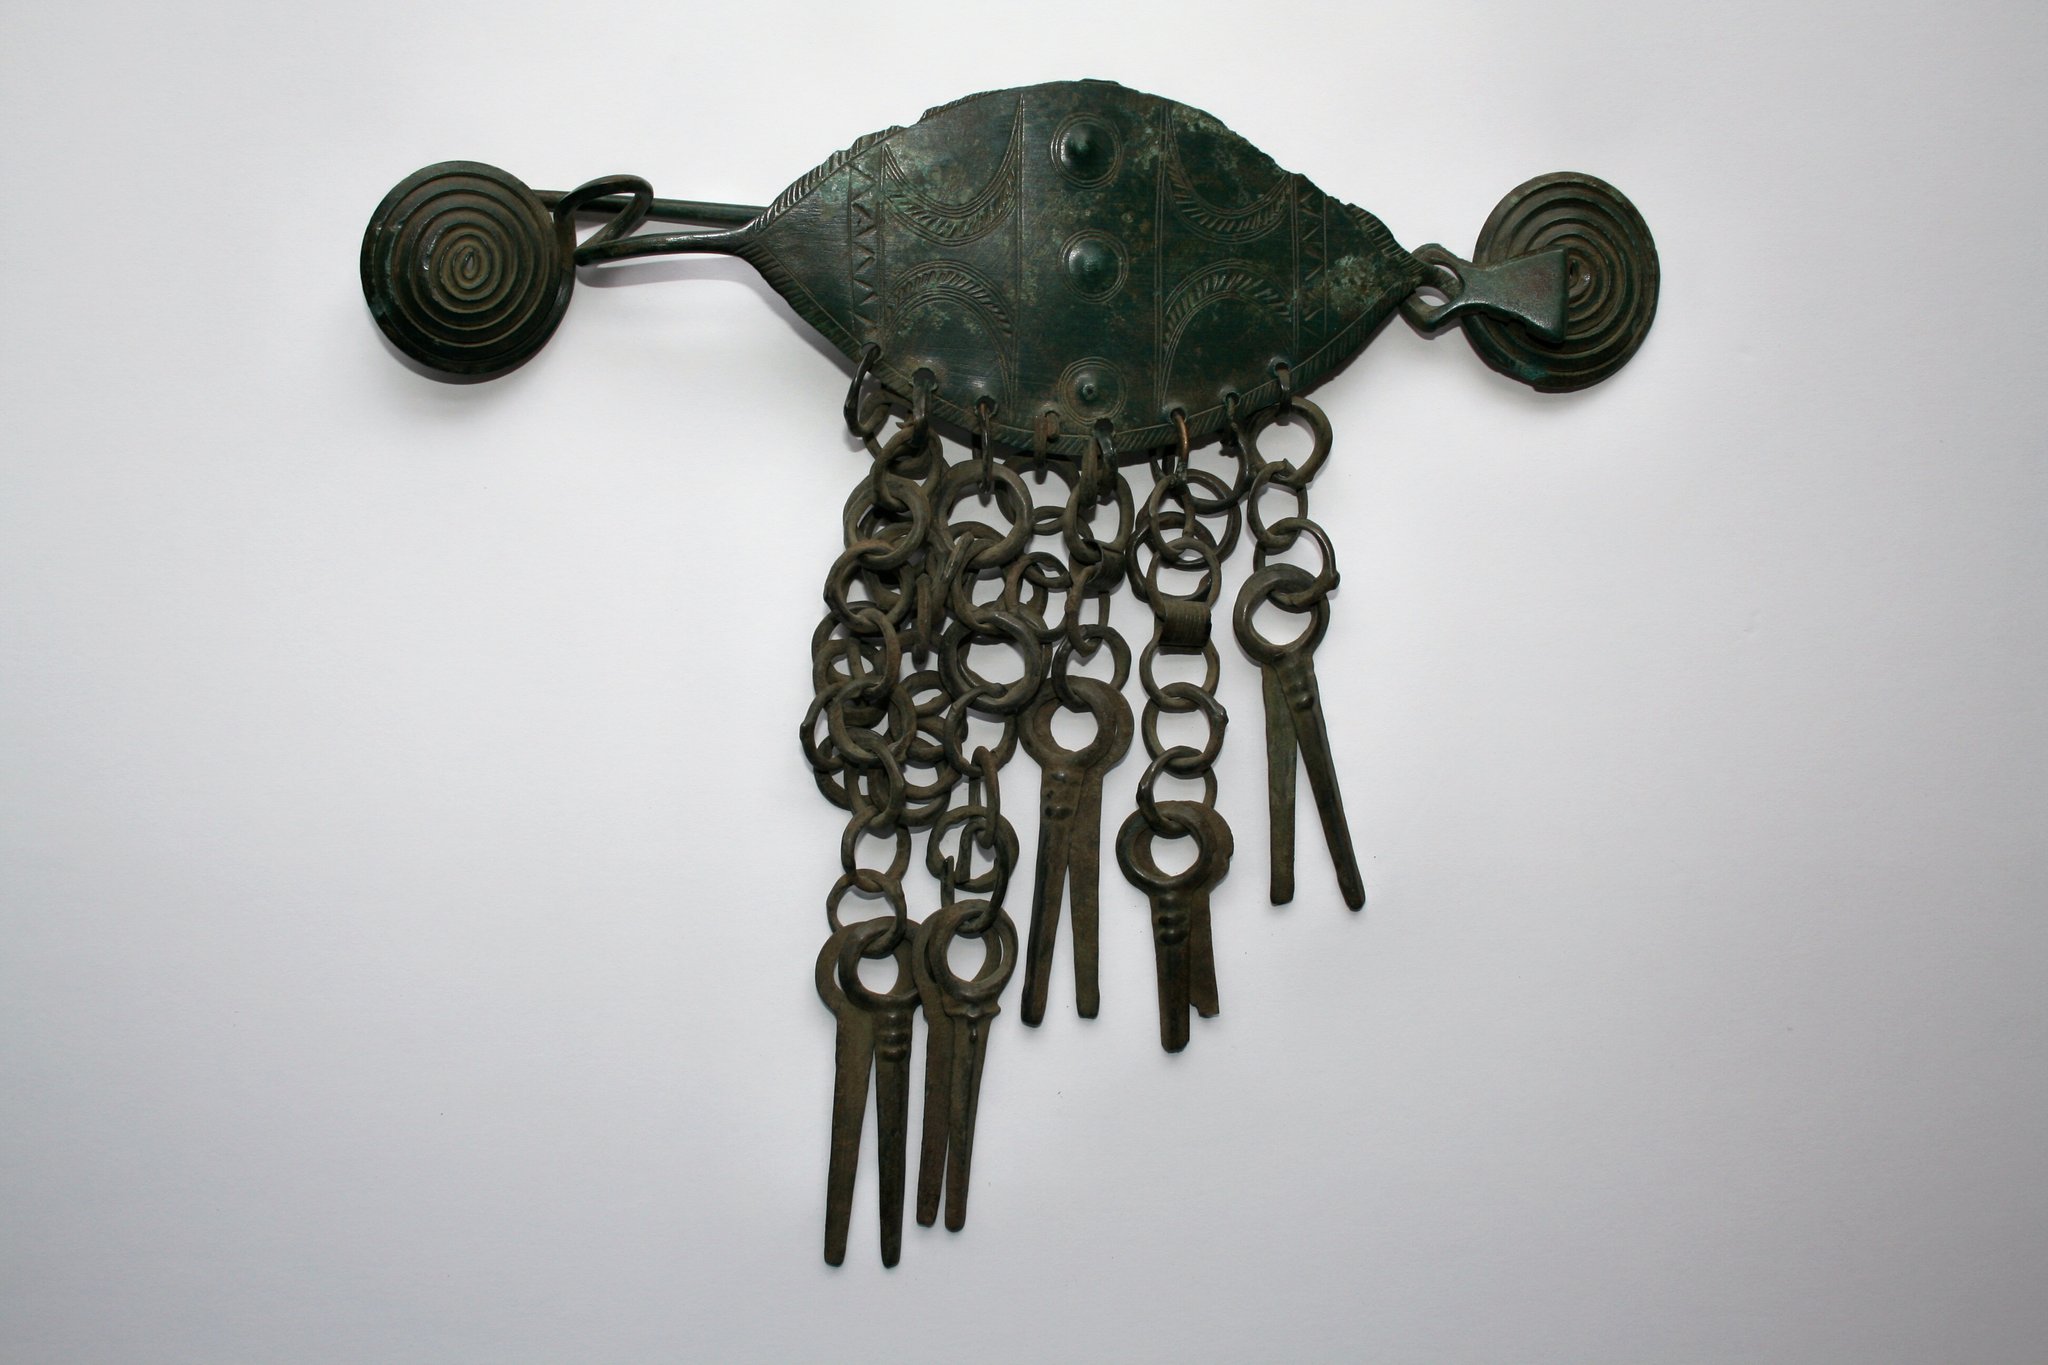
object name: brooch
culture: european bronze age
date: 1000-800 BCE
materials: copper alloy